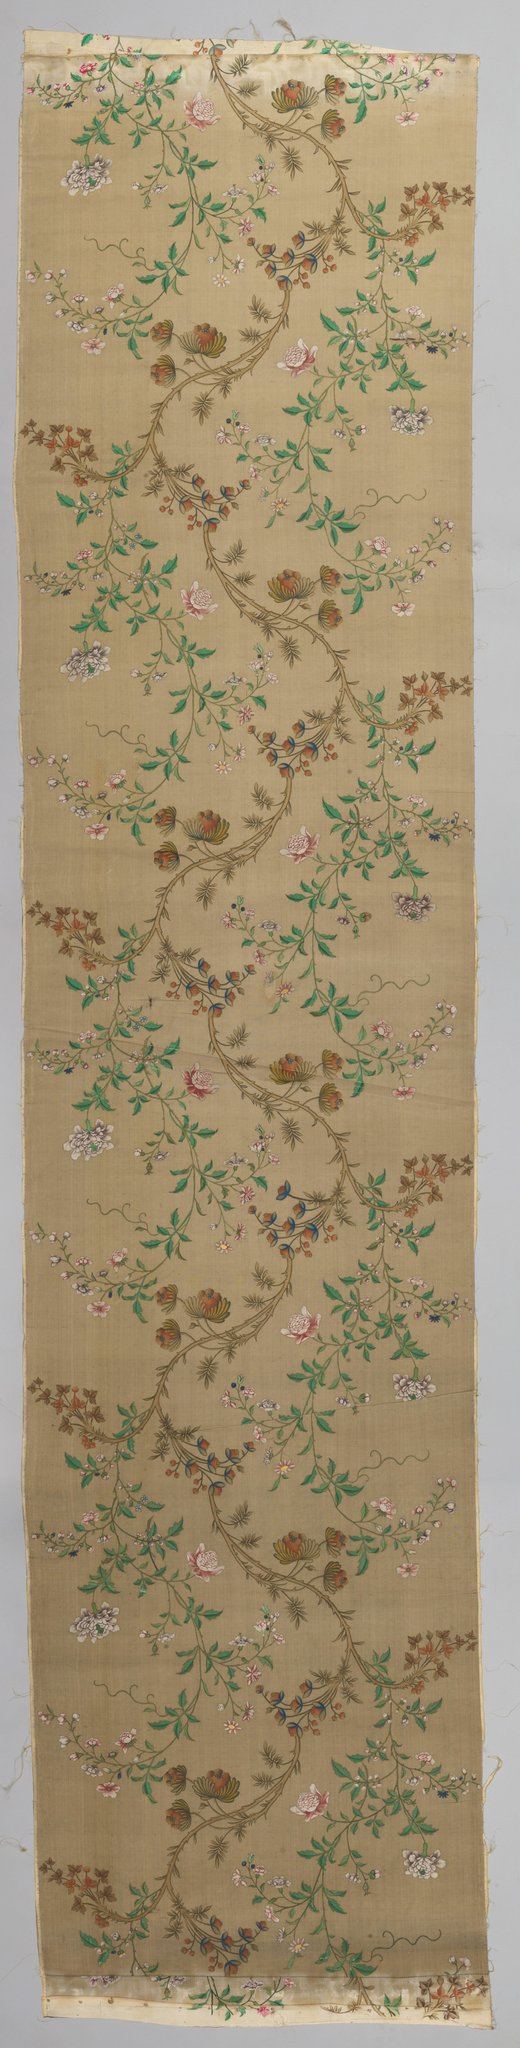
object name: upholstery fabric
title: Bespanningsstof met decor van takken, bladeren, bloemen en vruchten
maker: Anonymous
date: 1750-1790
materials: paint, silk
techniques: printing, weave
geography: china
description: Een baan veelkleurig beschilderde creme bespanningsstof van zijde. Zie beschrijving A.